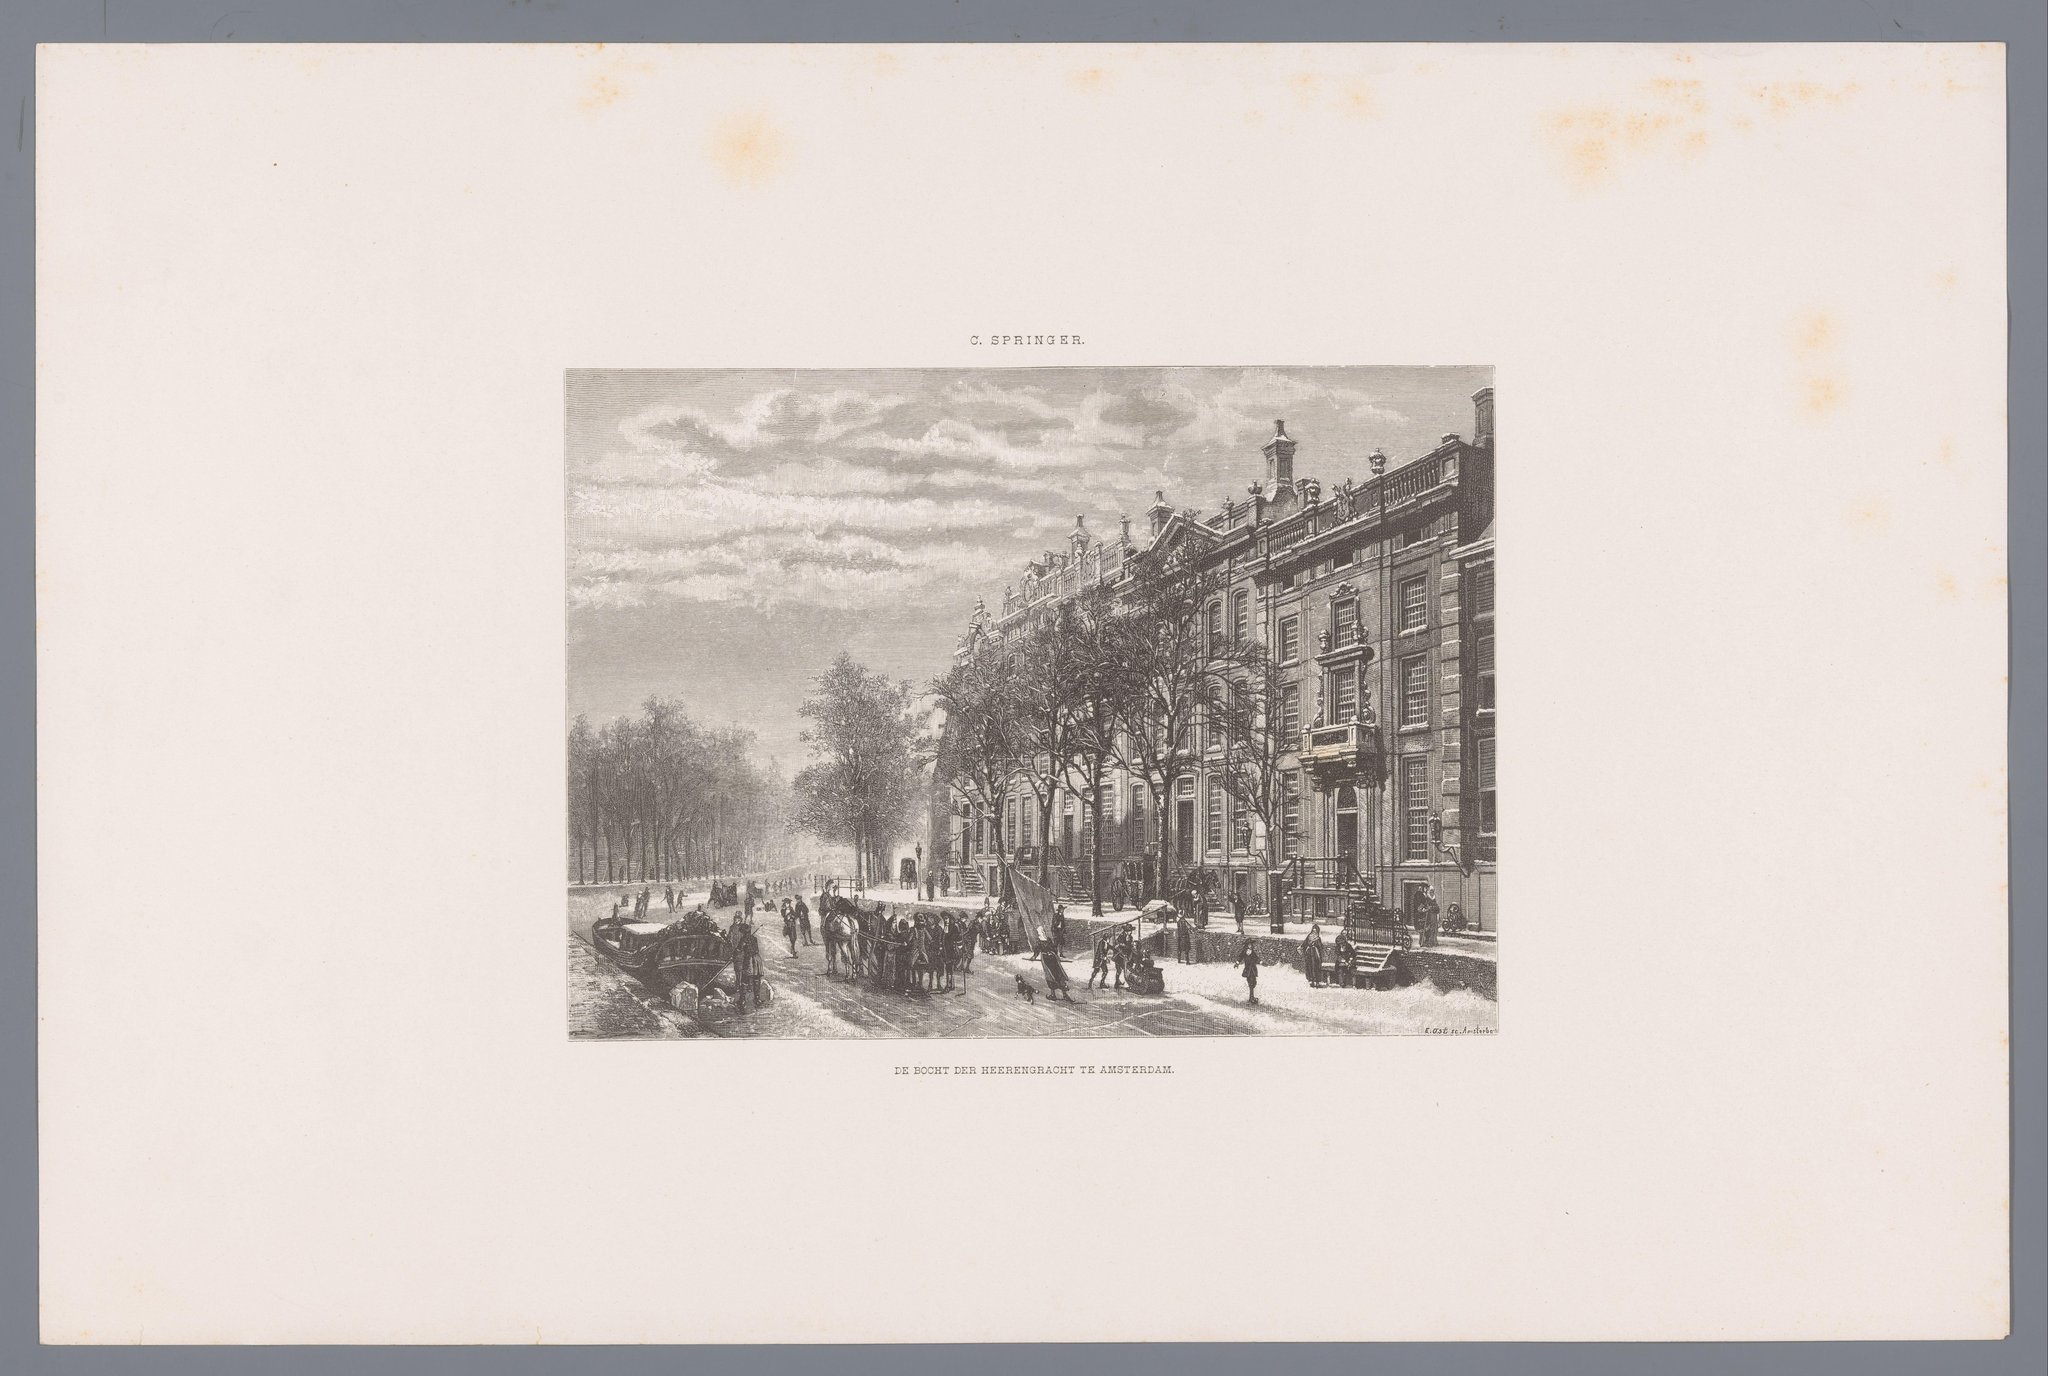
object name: print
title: Wintergezicht op de bocht in de Herengracht in Amsterdam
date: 1856-1946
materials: paper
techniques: letterpress printing, engraving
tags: sleigh, sledge (non-sport), skates (winter sports), bridge in city across river, canal, etc.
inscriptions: collector's mark: Lugt 2233